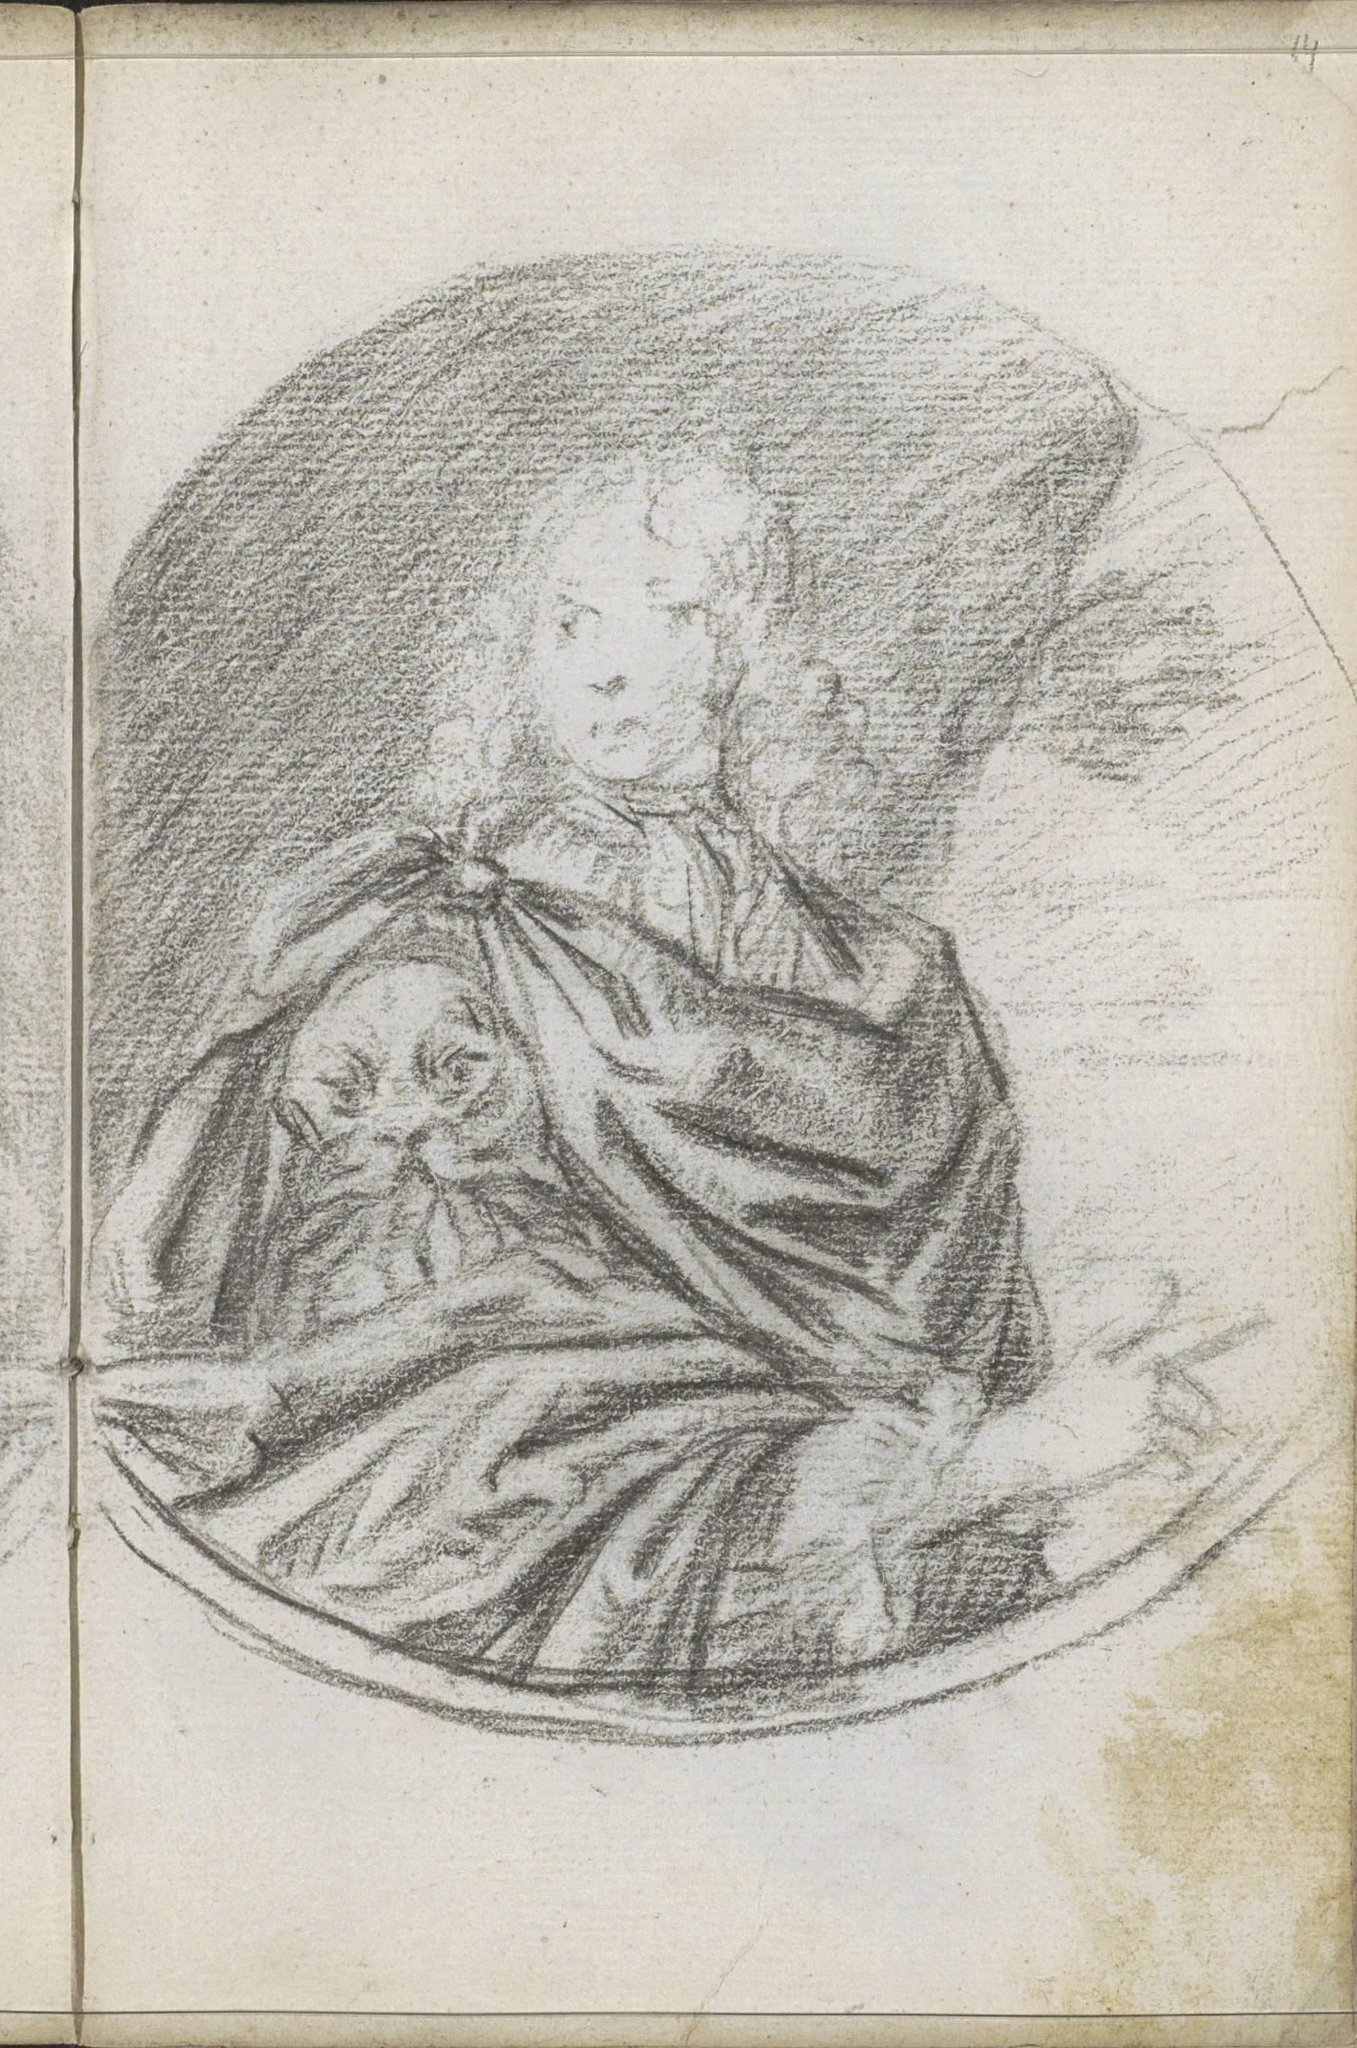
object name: sketchbook leaf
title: Portret van een man met uitgestoken hand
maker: petrus johannes van reysschoot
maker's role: draughtsman, print maker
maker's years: 1702-1772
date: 1710-1772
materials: chalk, paper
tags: anonymous historical person portrayed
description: Tekening in een cirkel. Blad 14 recto uit een schetsboek met 105 bladen.